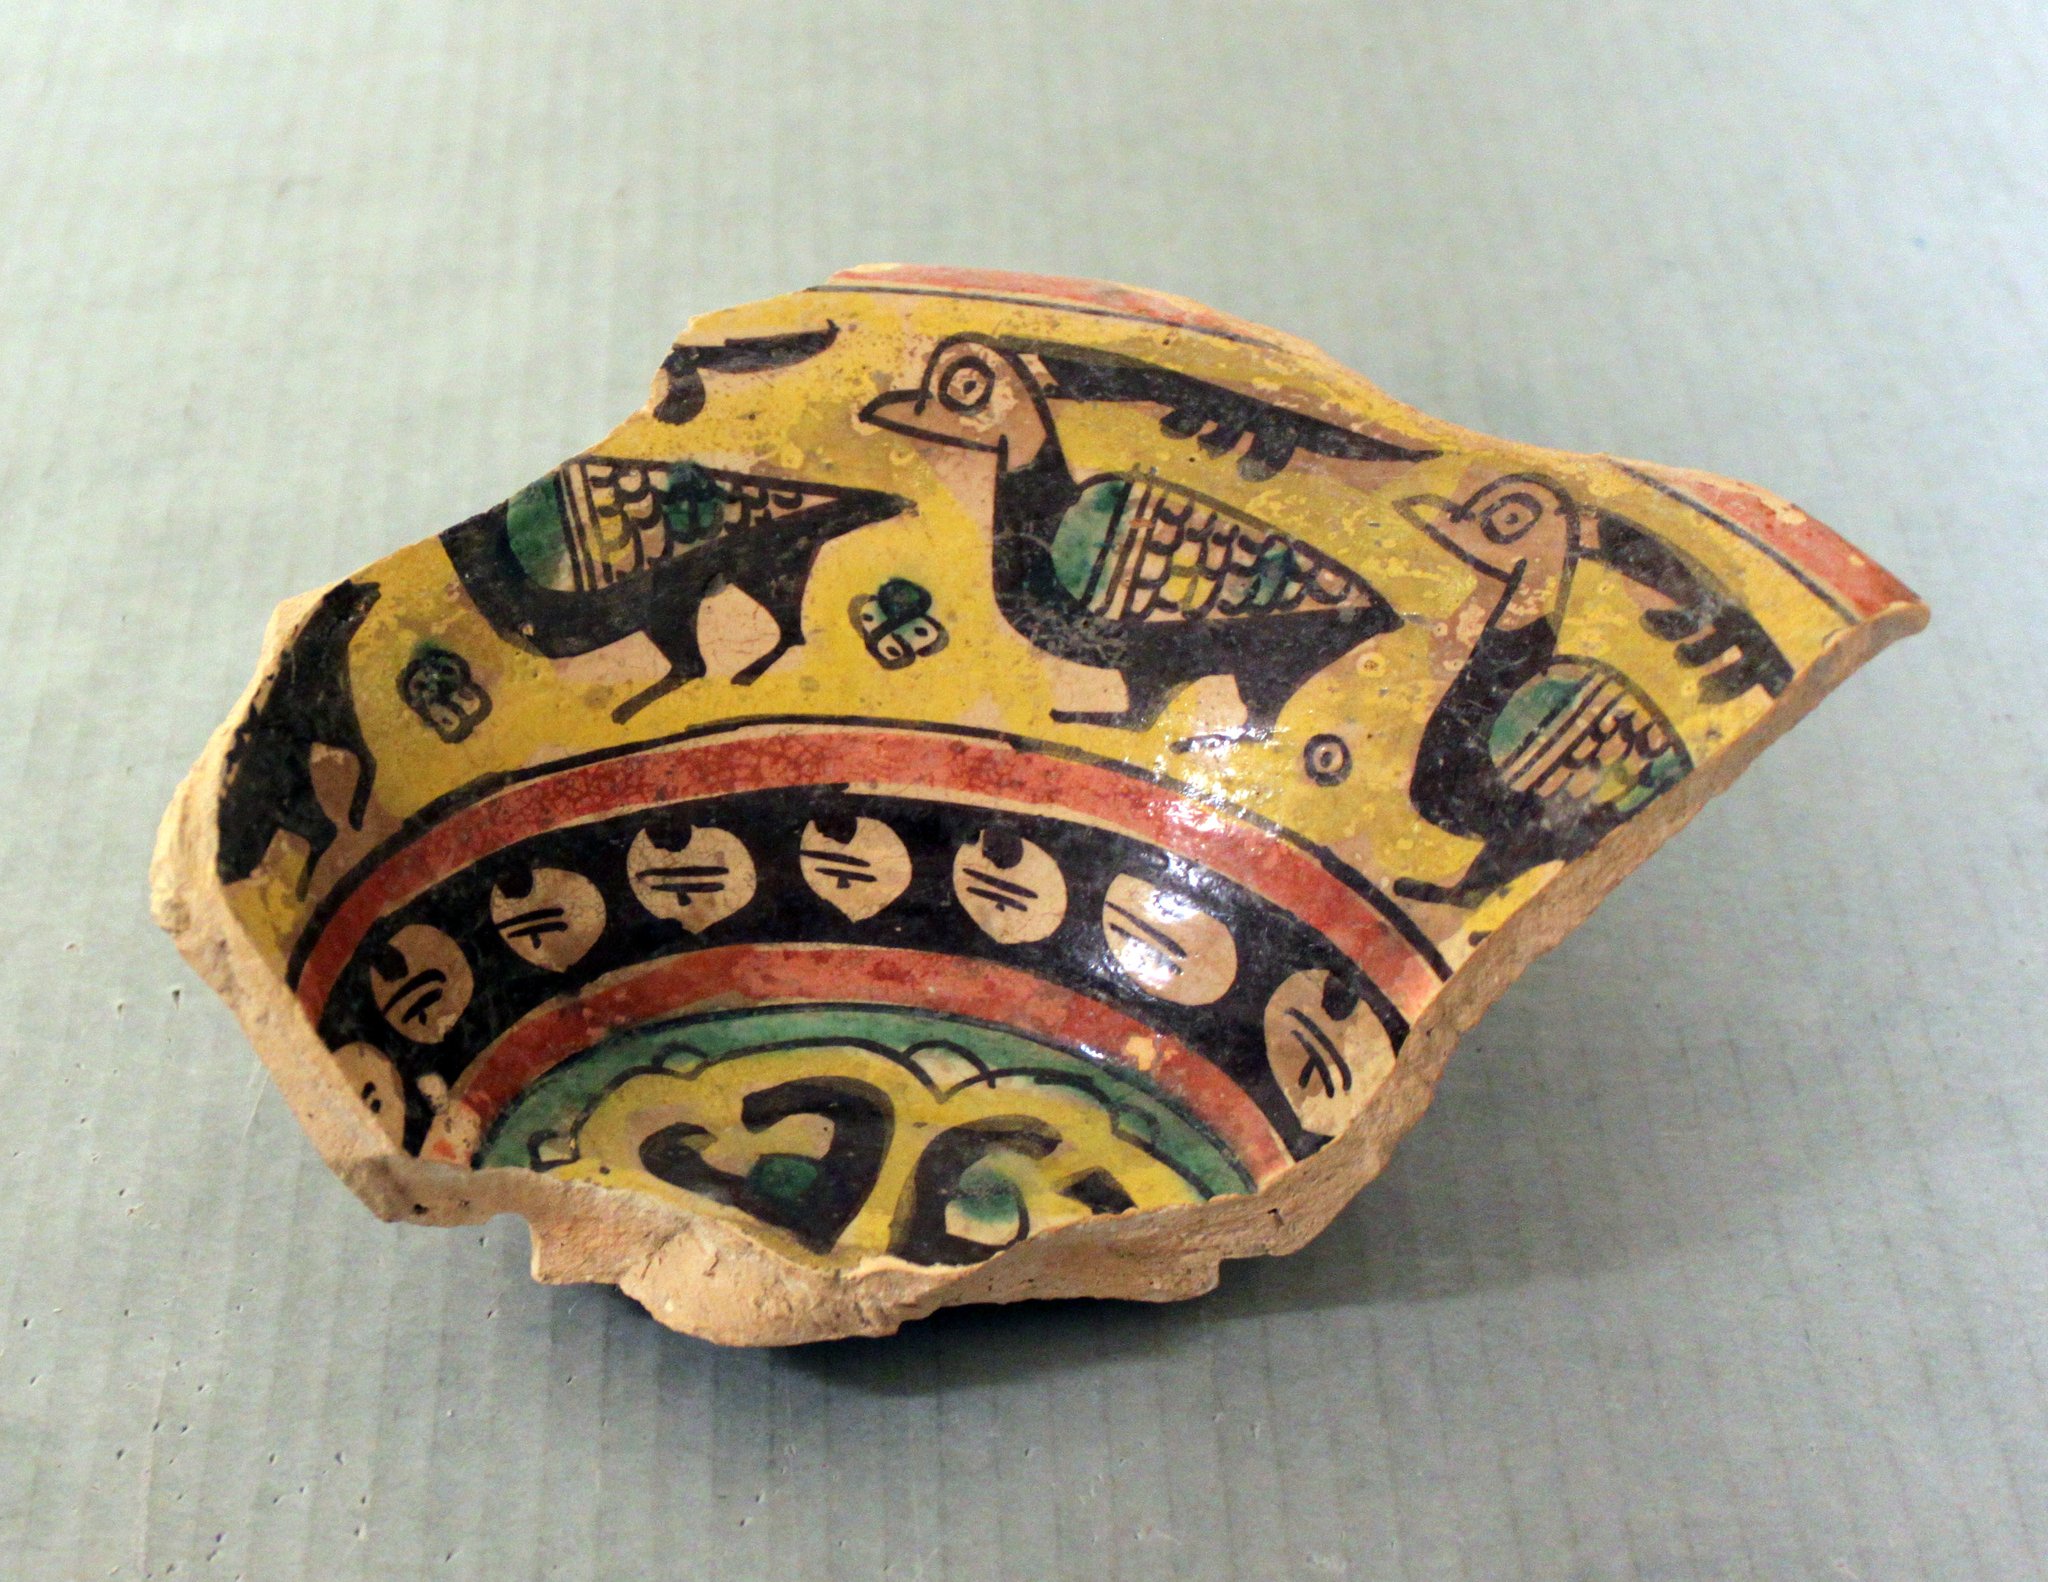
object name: fragment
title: Fragment of a Bowl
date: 801-1000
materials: earthenware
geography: iran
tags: birds